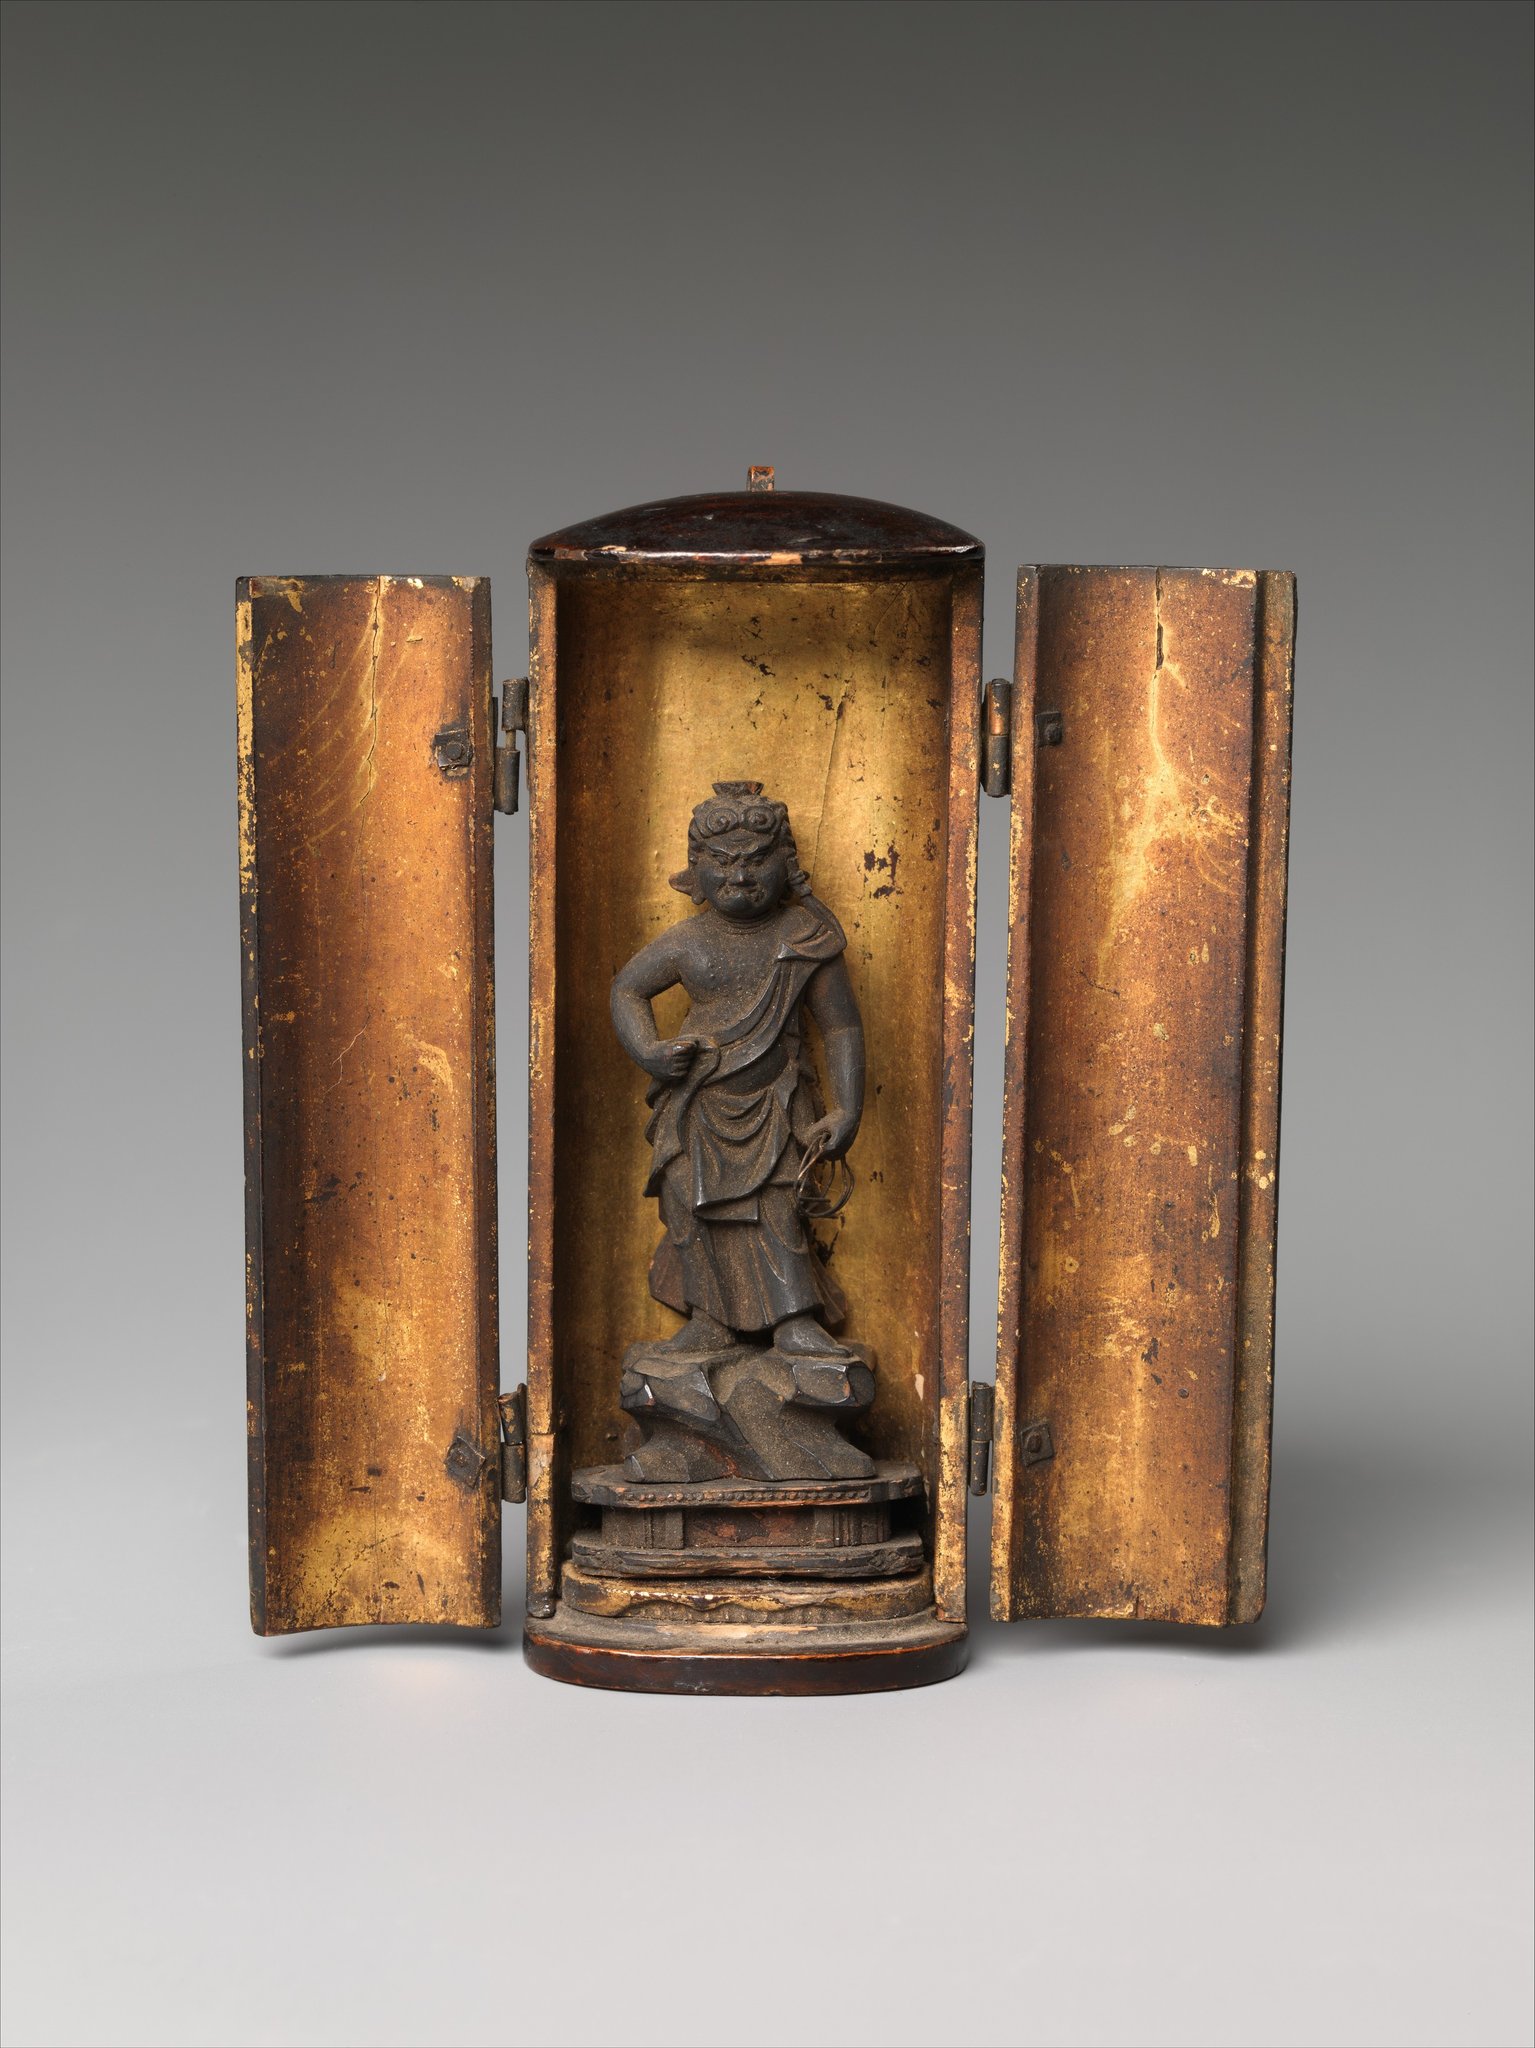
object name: portable shrine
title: Portable Shrine (zushi) with Fudō Myōō, the Immovable Wisdom King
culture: japanese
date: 1701-1800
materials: gold, lacquer, metal, wood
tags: buddhism,deities